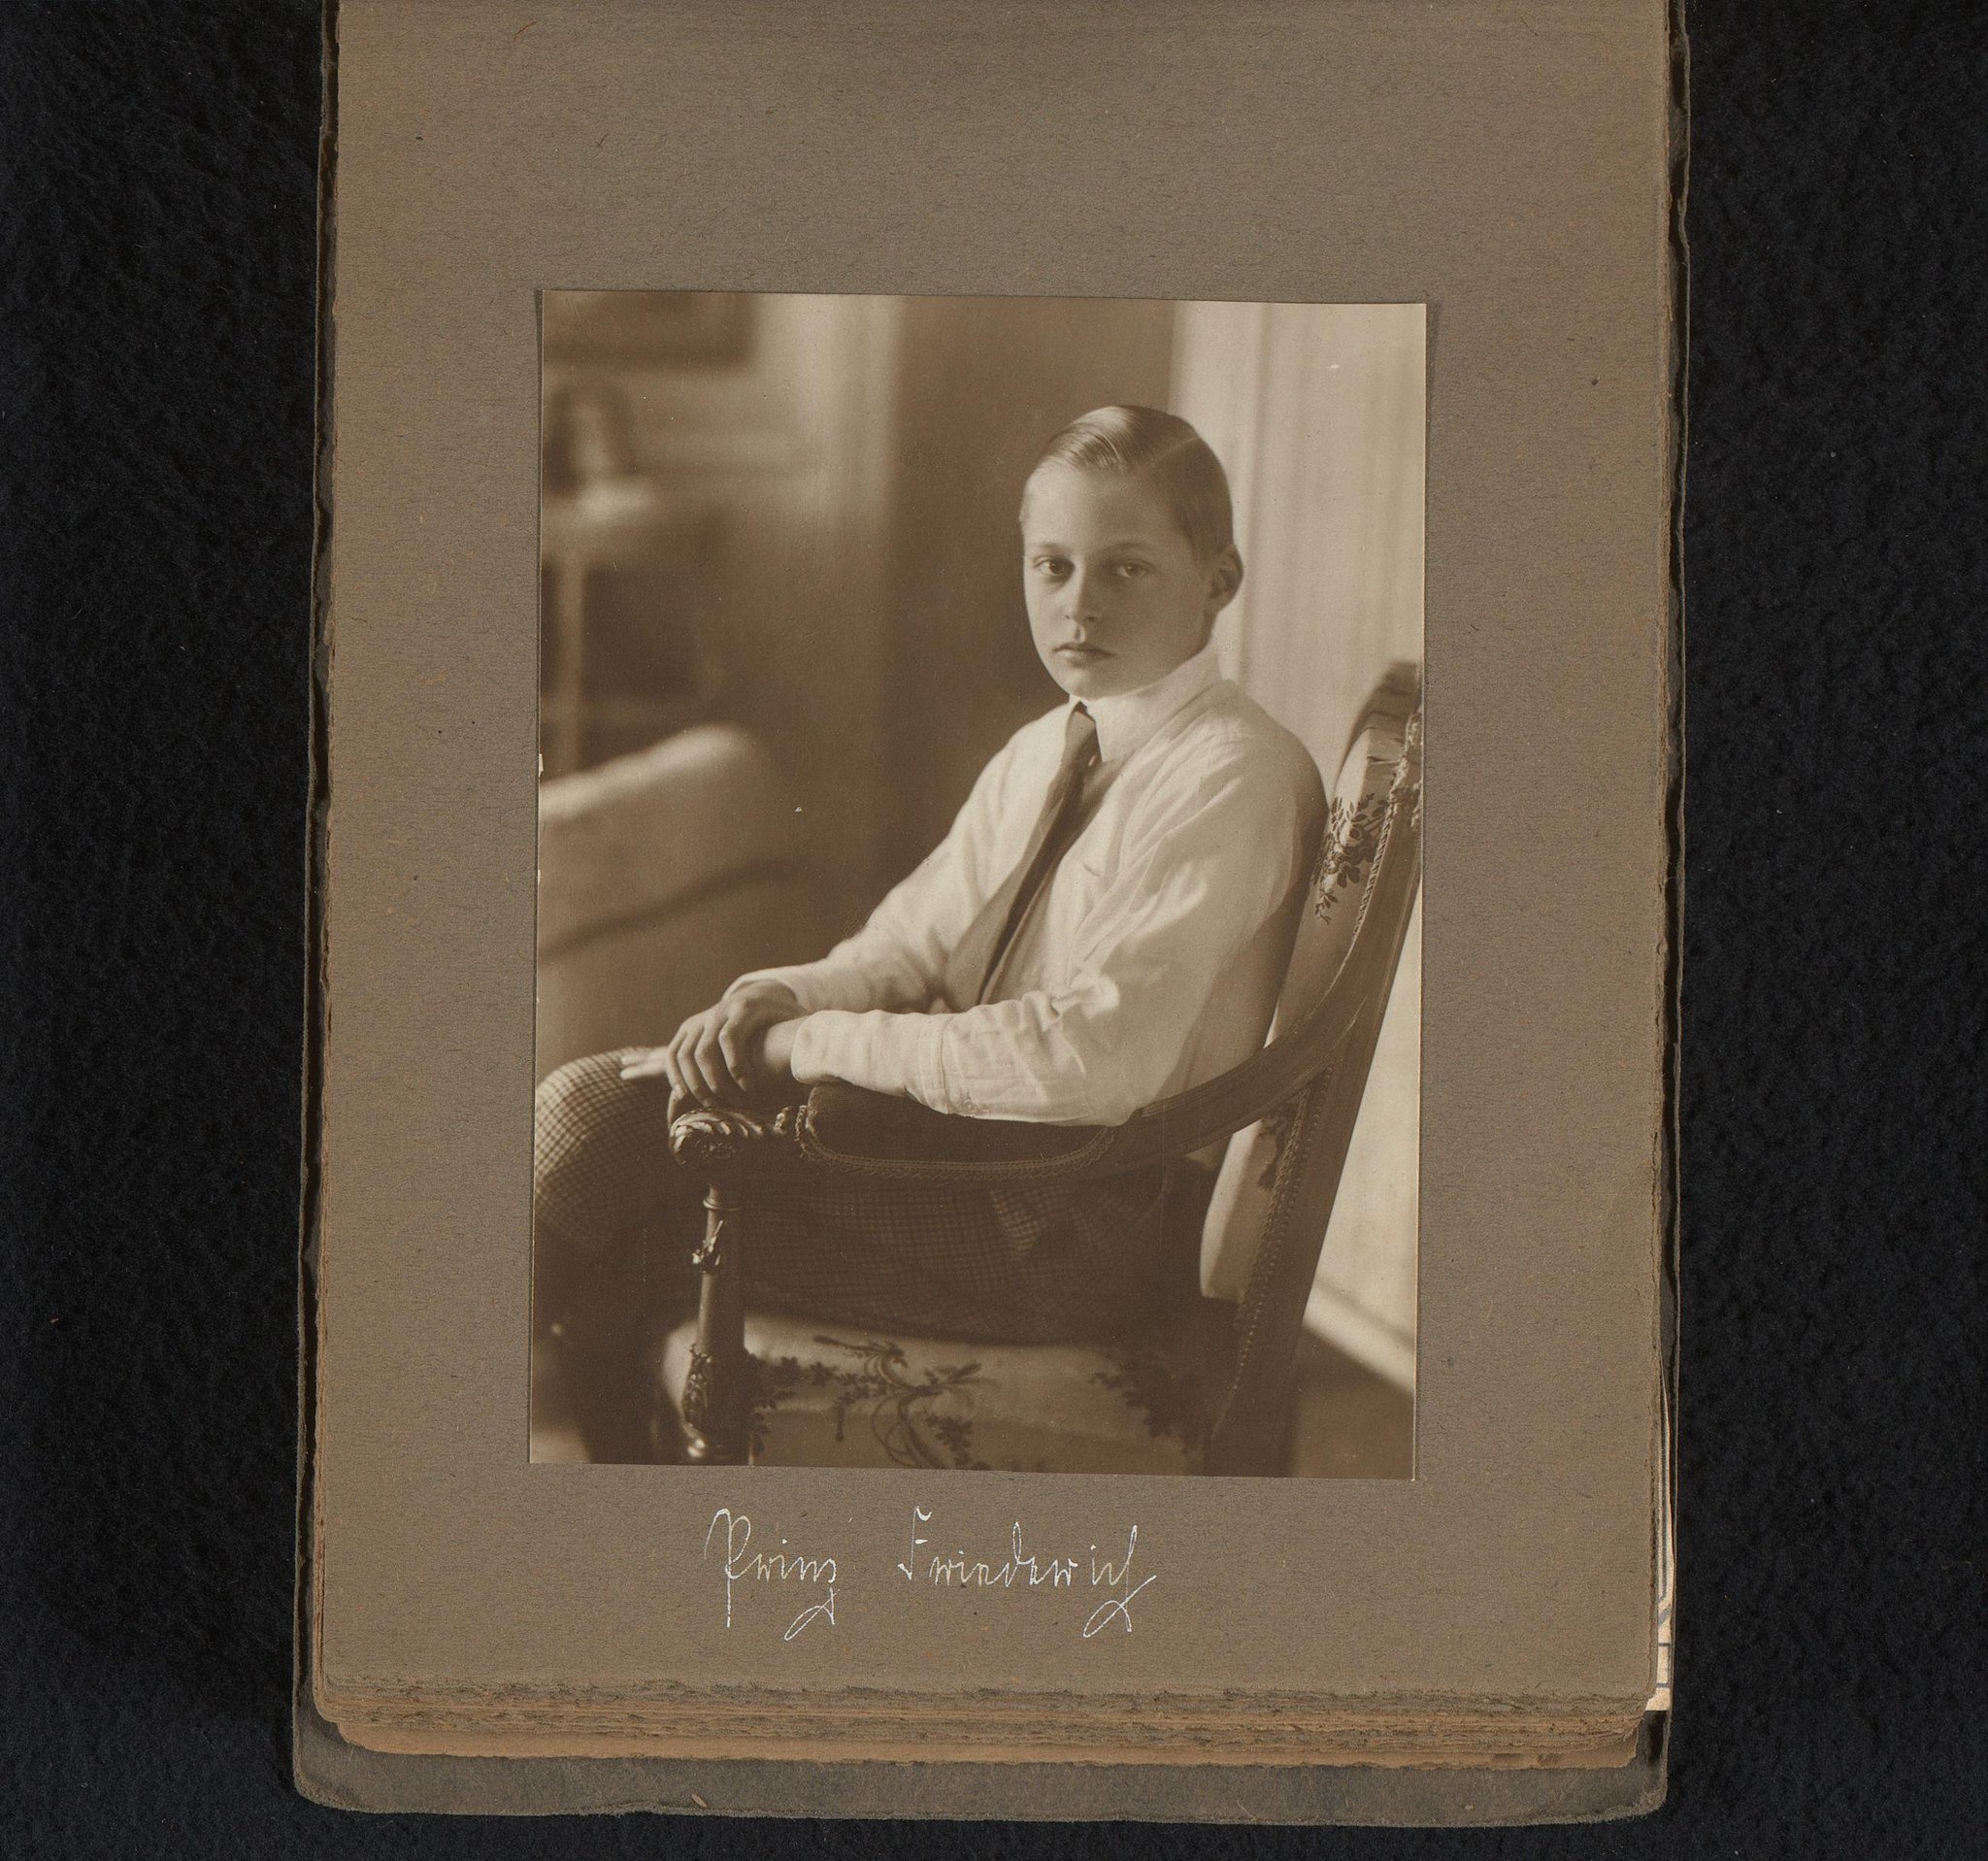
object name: photograph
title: Prinz Friedrich von Preußen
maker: Anonymous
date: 1917-1925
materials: paper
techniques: gelatin silver print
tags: berlin, prince, historical persons